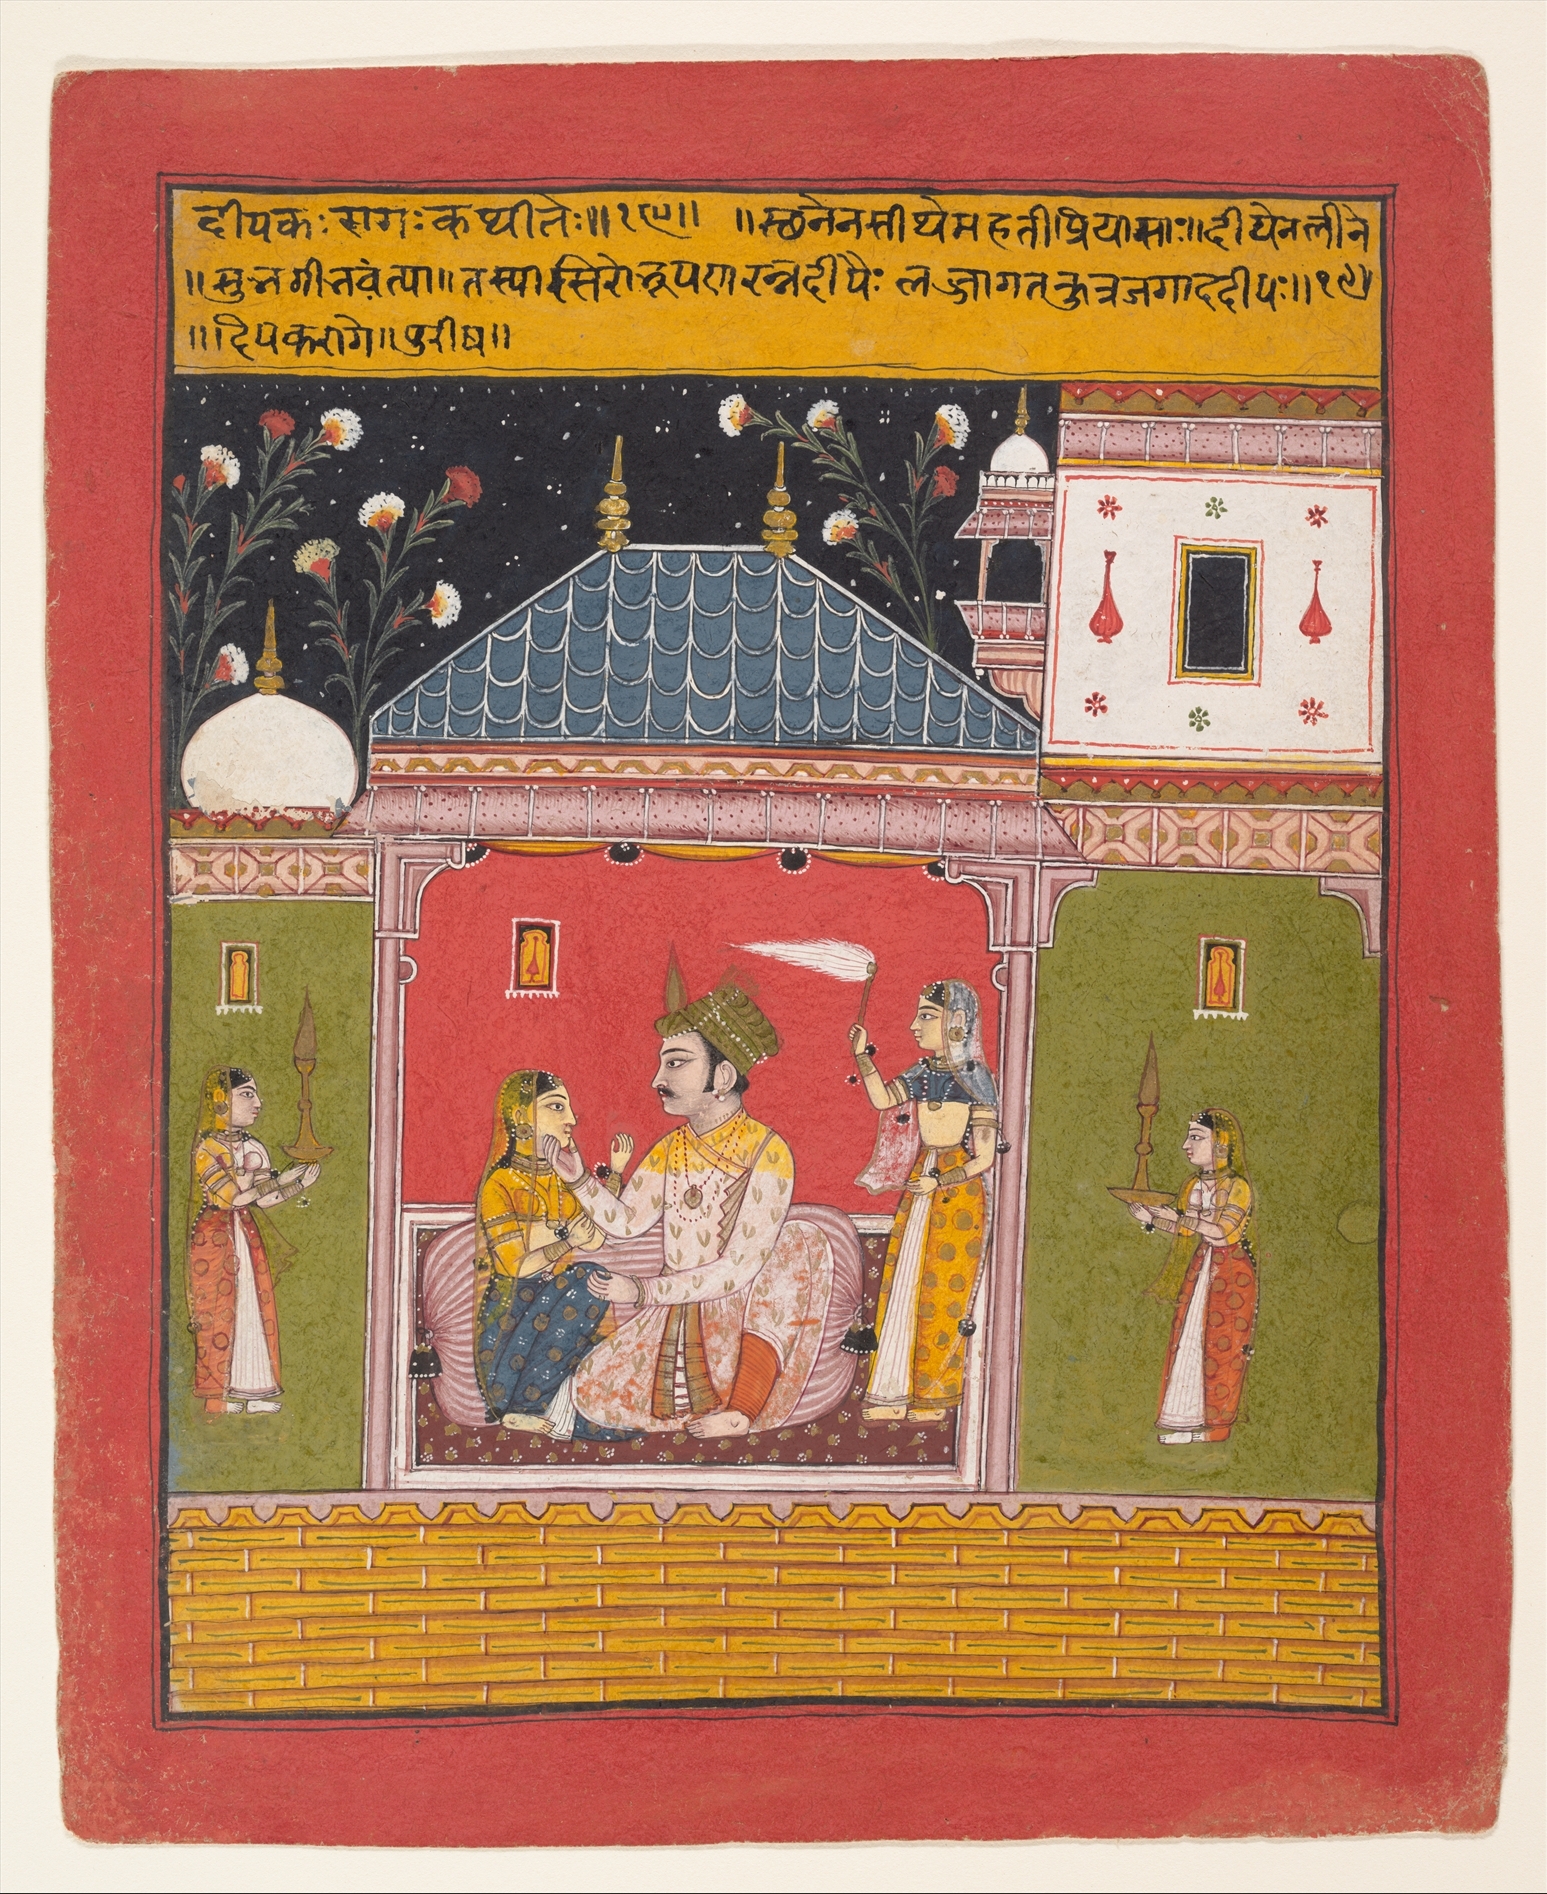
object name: folio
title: Dipak Raga: Folio from a Ragamala Series (Garland of Musical Modes)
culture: indian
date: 1630-1640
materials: ink, paper, watercolor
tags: men,women,lamps,pavilions